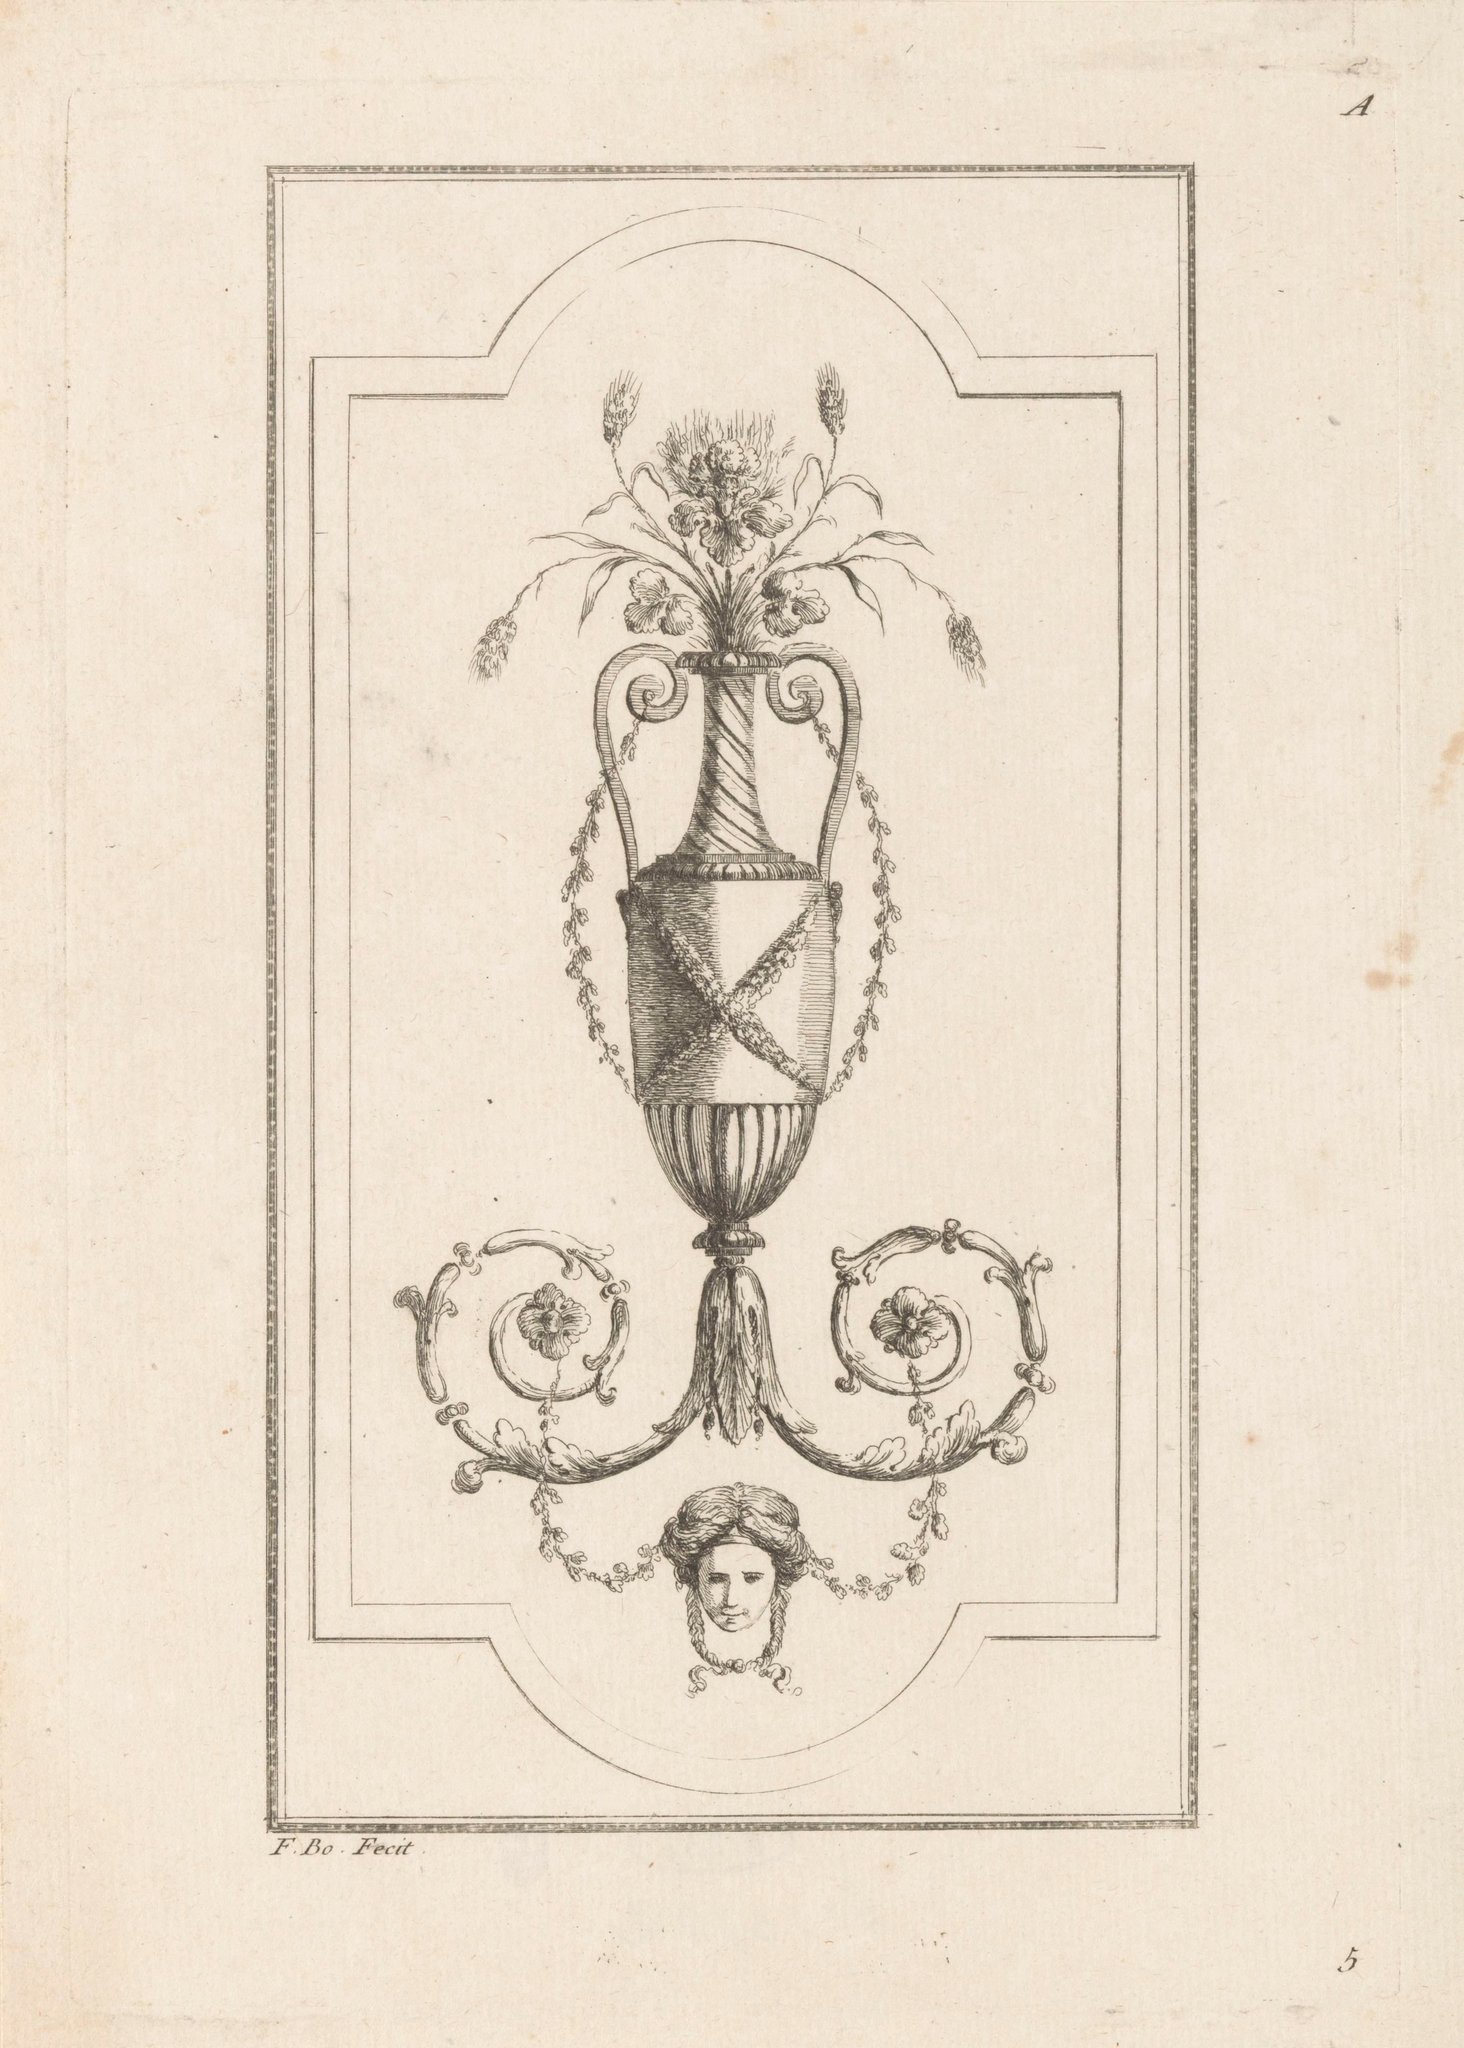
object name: print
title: A Ve Suite d'Arabesques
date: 1752-1782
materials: paper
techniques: etching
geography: paris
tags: ornament ~ arabesque, mask, mascaron ~ ornament, flowers in a vase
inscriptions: collector's mark: Lugt 2228, collector's mark: Lugt 2760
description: Een vaas met bloemen, aan de onderzijde arabesken met een masker.